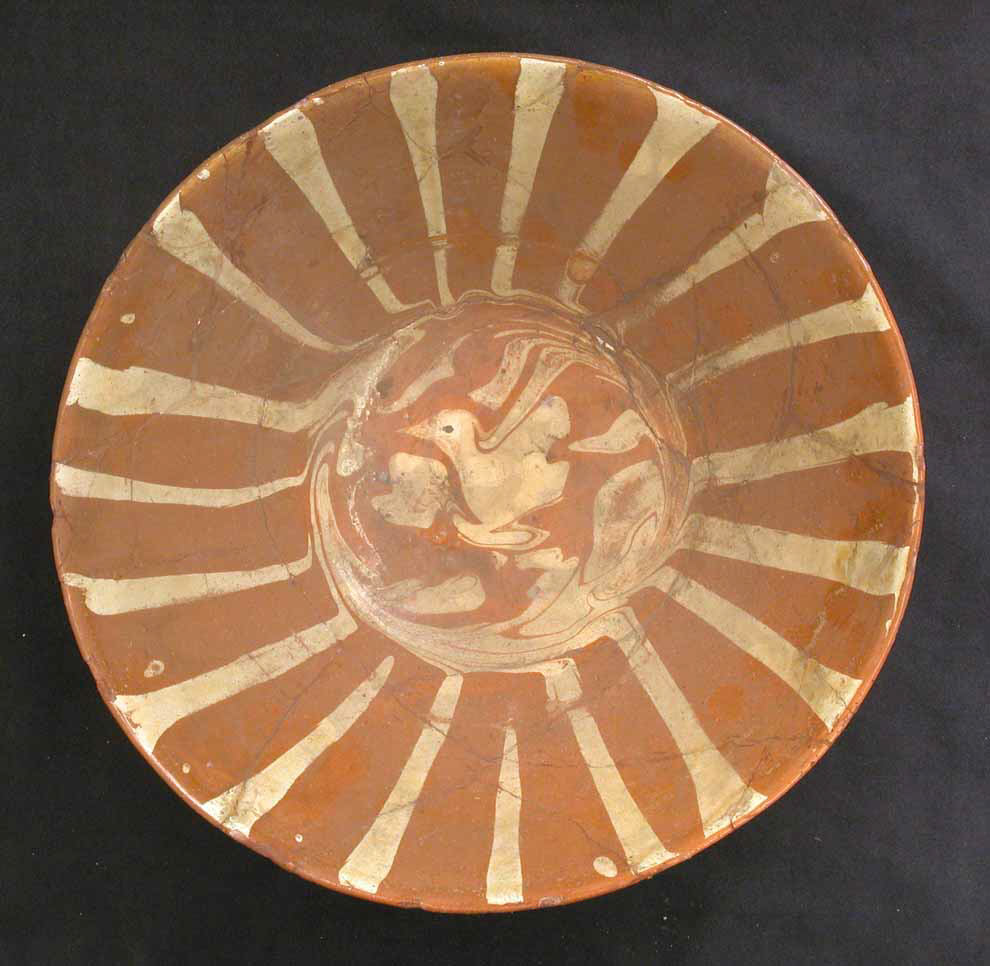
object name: bowl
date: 1401-1600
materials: earthenware, glaze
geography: iran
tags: birds